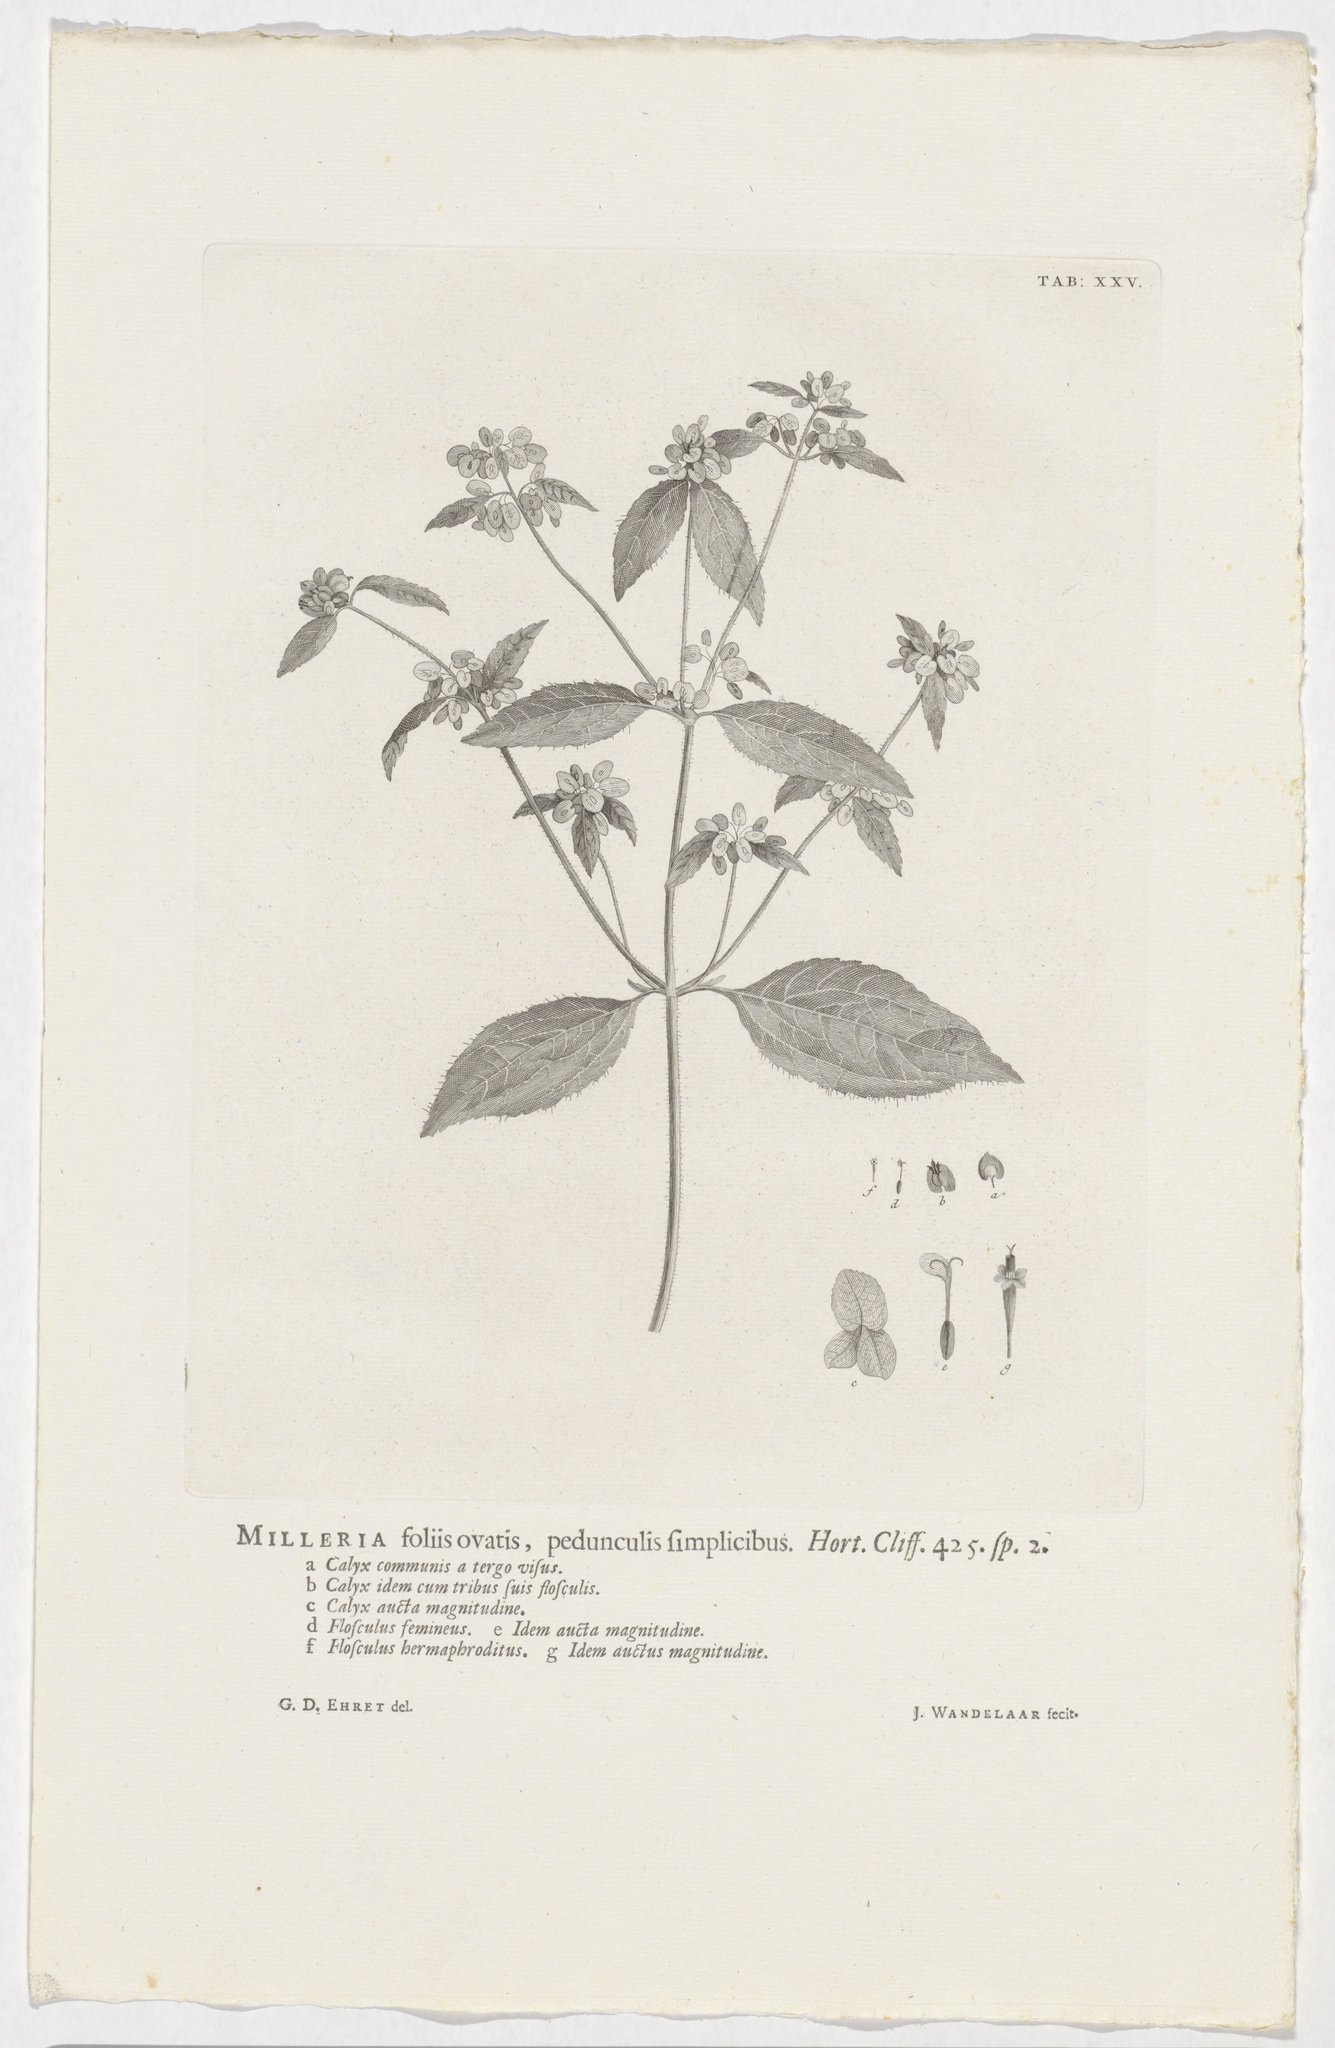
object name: book illustration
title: Milleria foliis ovatis, pedunculis simplicibus. Hort. Cliff. 425. sp. 2.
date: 1738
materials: paper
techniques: etching, letterpress printing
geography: warmond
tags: flowers, plants and herbs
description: Prent gebruikt als illustratie in: Linnaeus, Carolus. Hortus Cliffortianus plantas exhibens quas in hortis tam vivis quam siccis, Hartecampi in Hollandia, coluit (...) Georgius Clifford. Amsterdam: sine nomen, 1738.